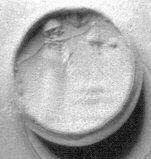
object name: stamp seal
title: Stamp seal (conoid) with cultic scene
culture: assyro-babylonian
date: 734-501 BCE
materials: stone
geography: mesopotamia